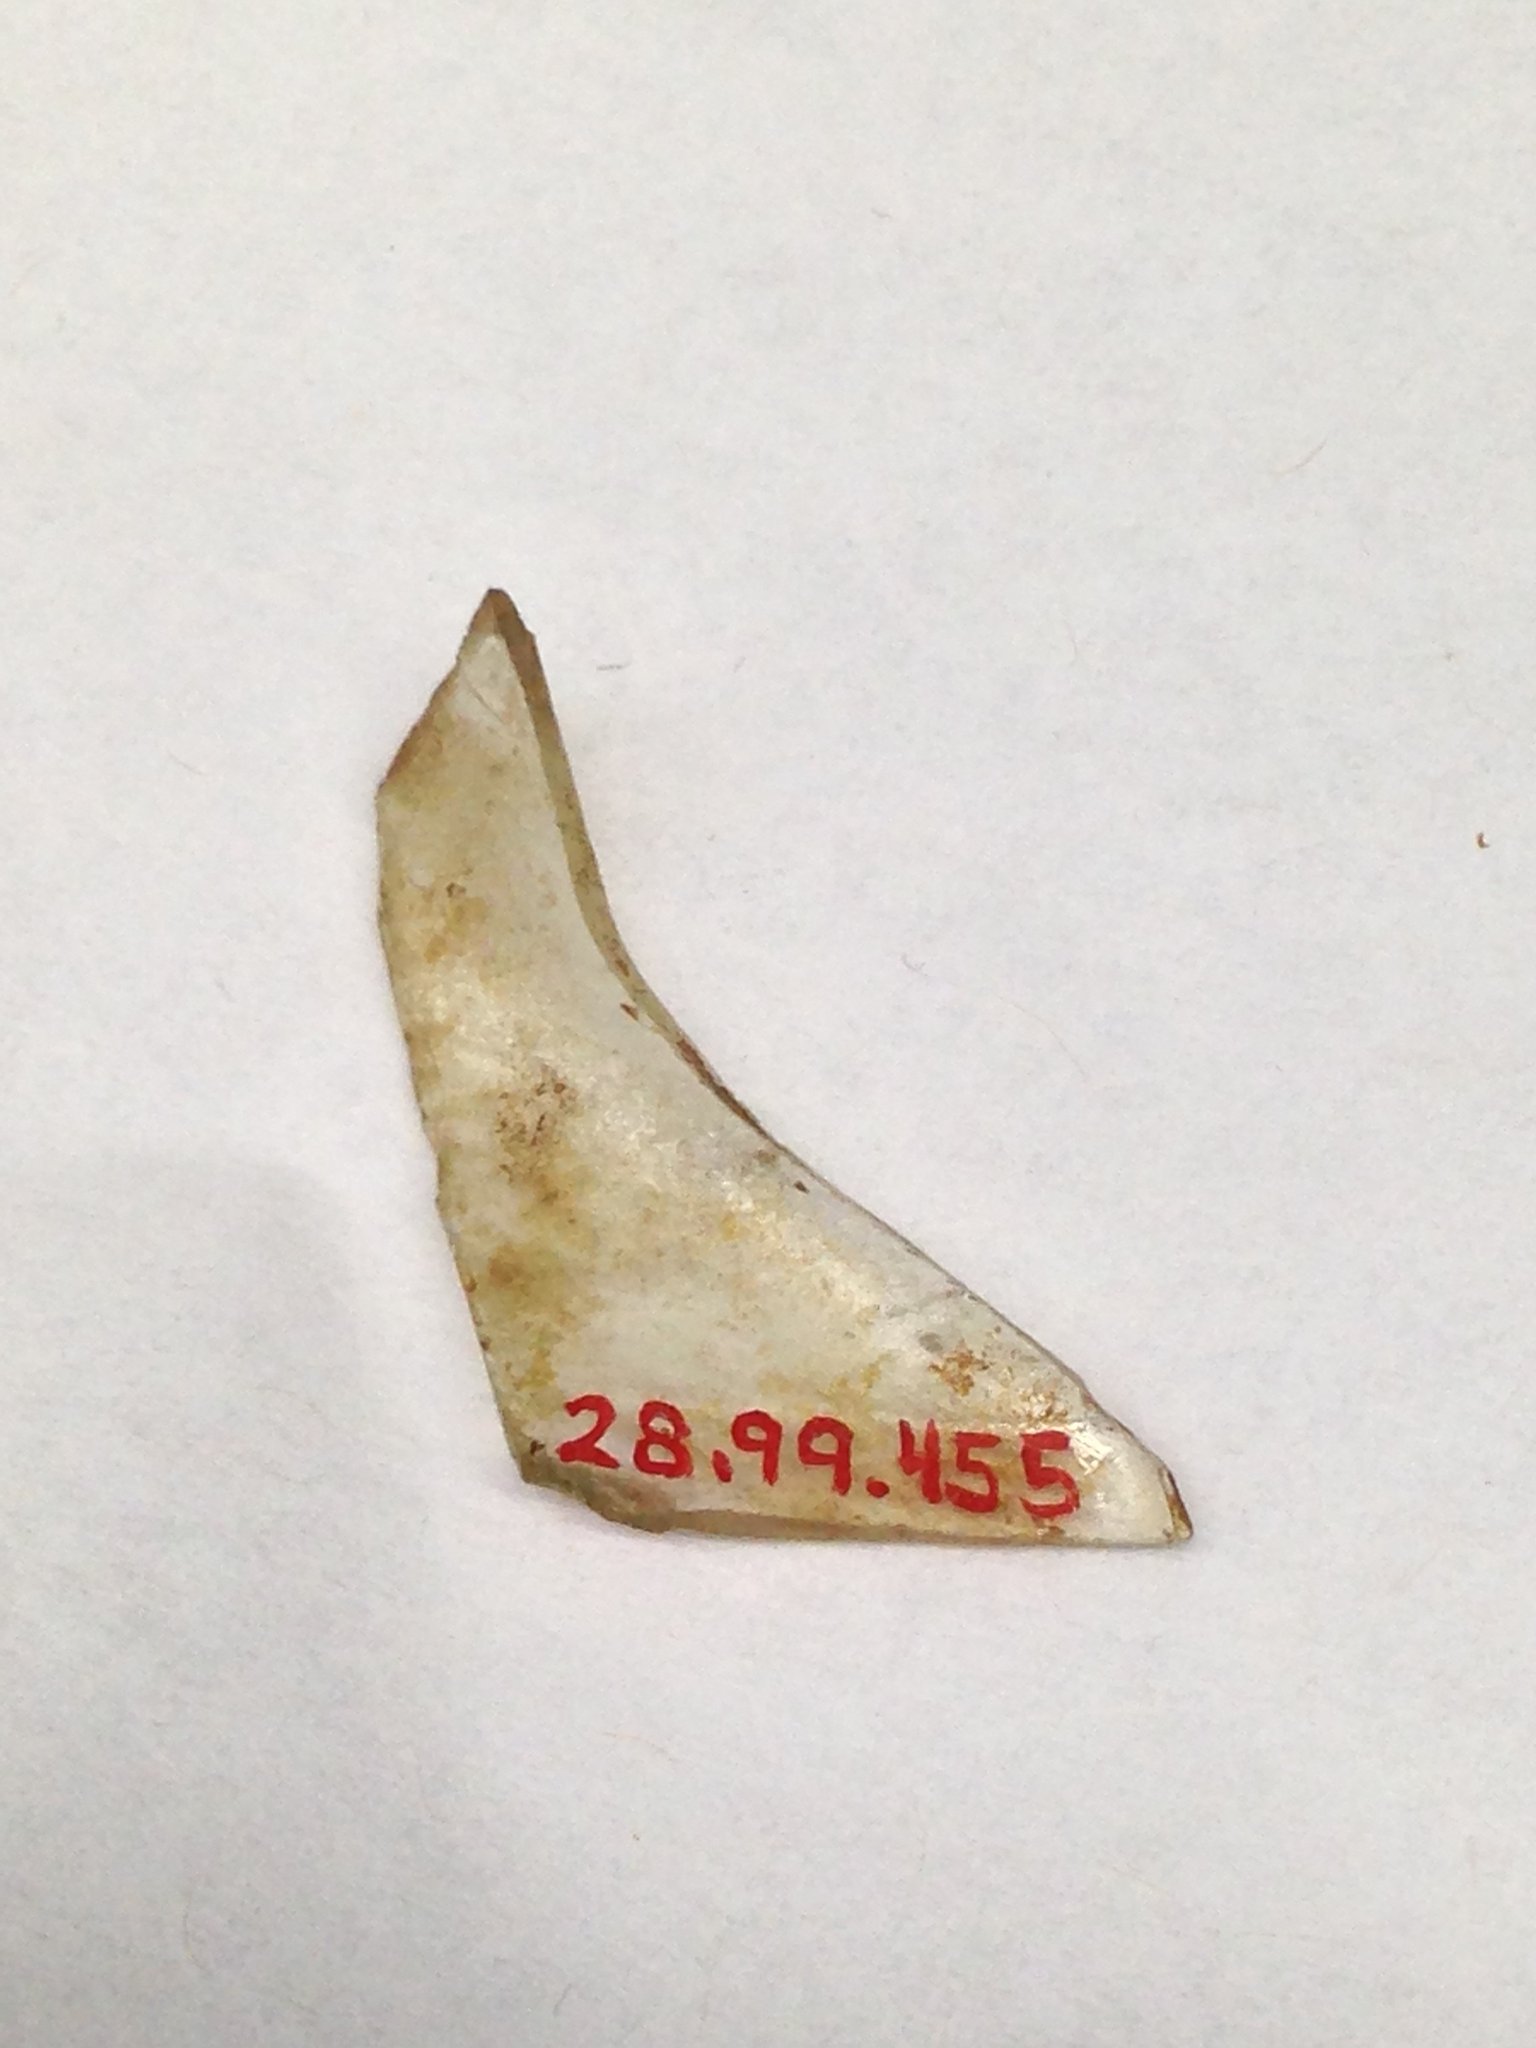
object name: fragment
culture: european or middle eastern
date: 1150-1250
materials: ceramic, glass